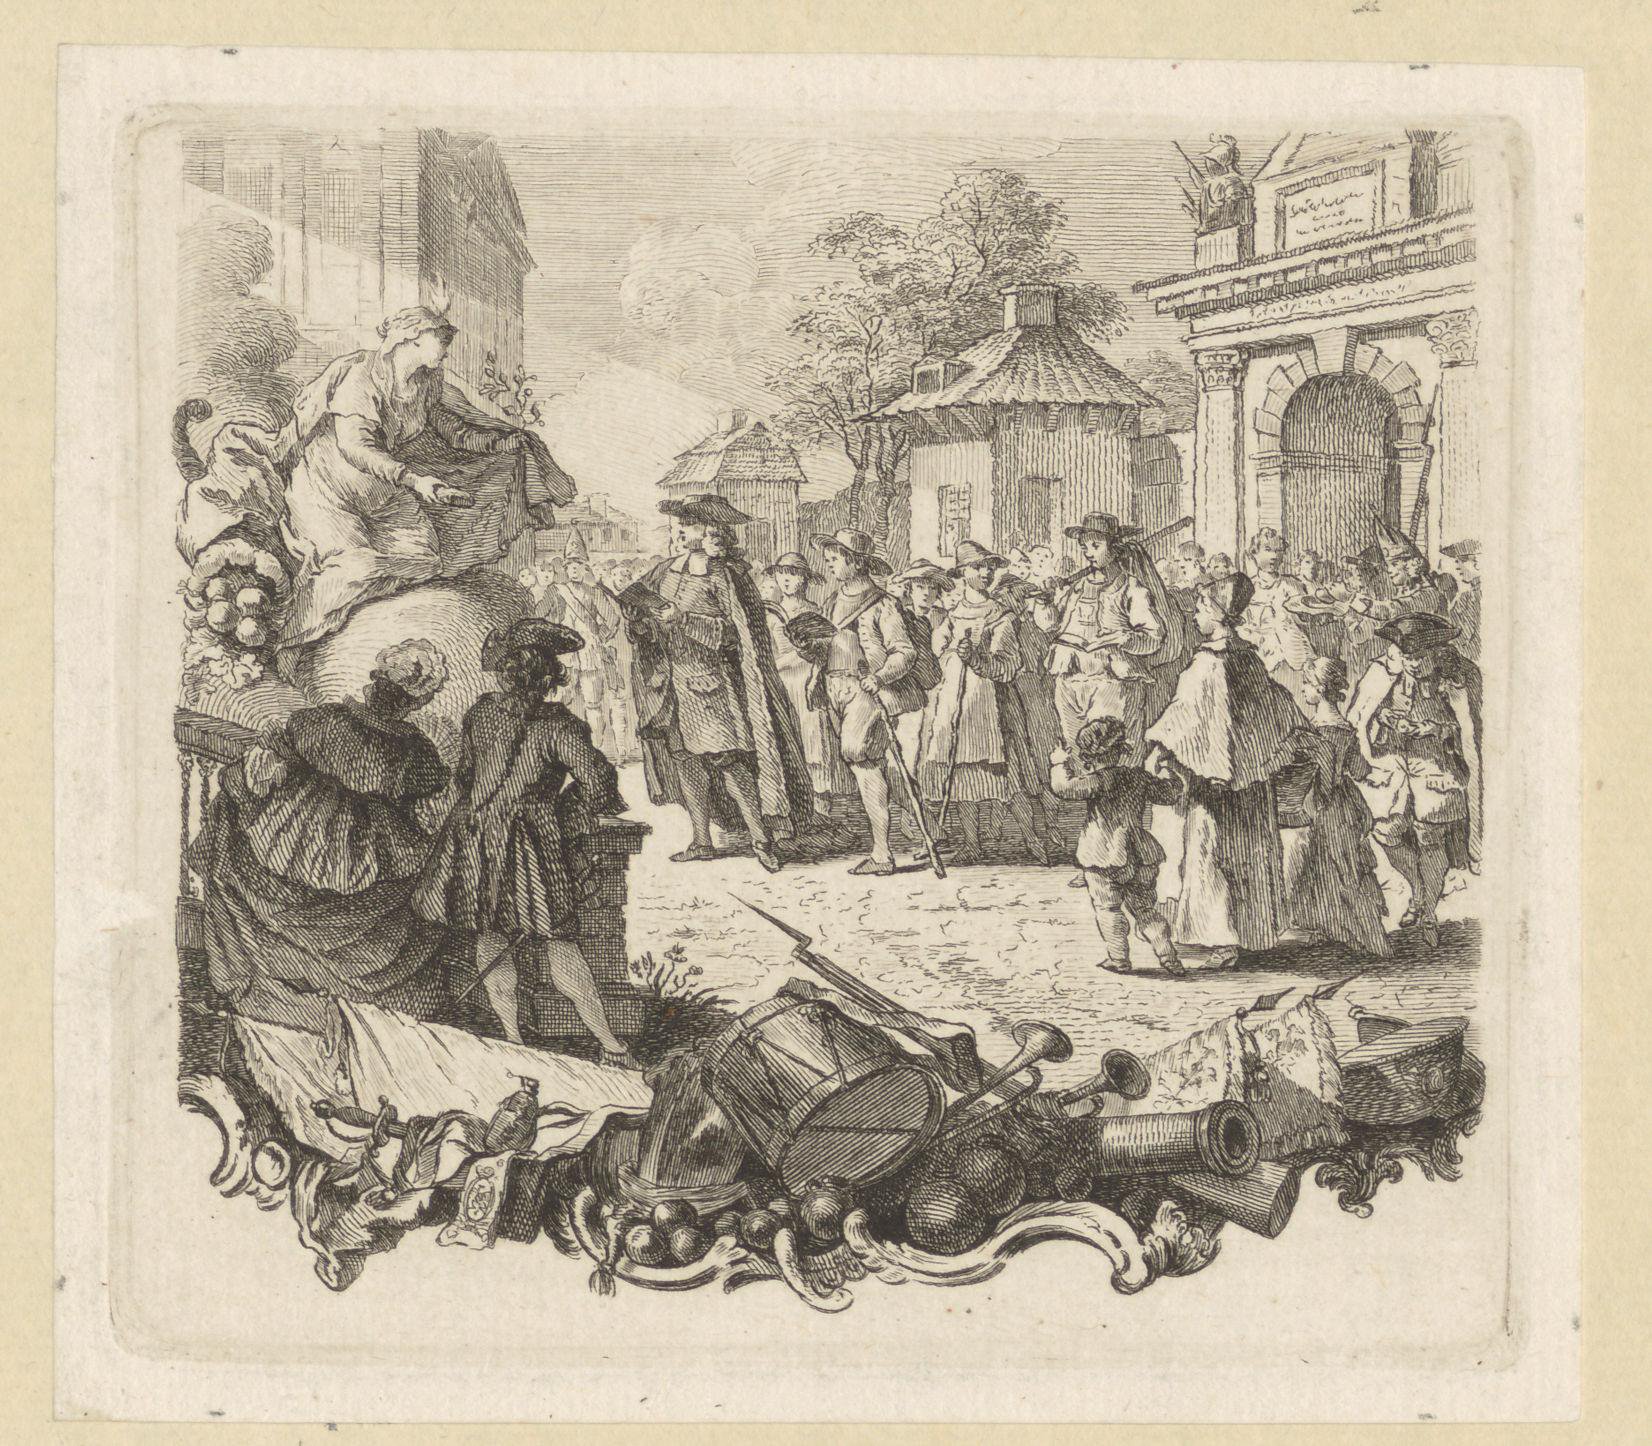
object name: book illustration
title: Verdreven Salzburgers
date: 1751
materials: paper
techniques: etching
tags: historical events and situations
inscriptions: collector's mark: Lugt 240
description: Prent ook gebruikt in: Frederik de Grote. Mémoires pour servir a l'histoire de la maison de Brandebourg. Sanssouci, Frederik de Grote, 1751.